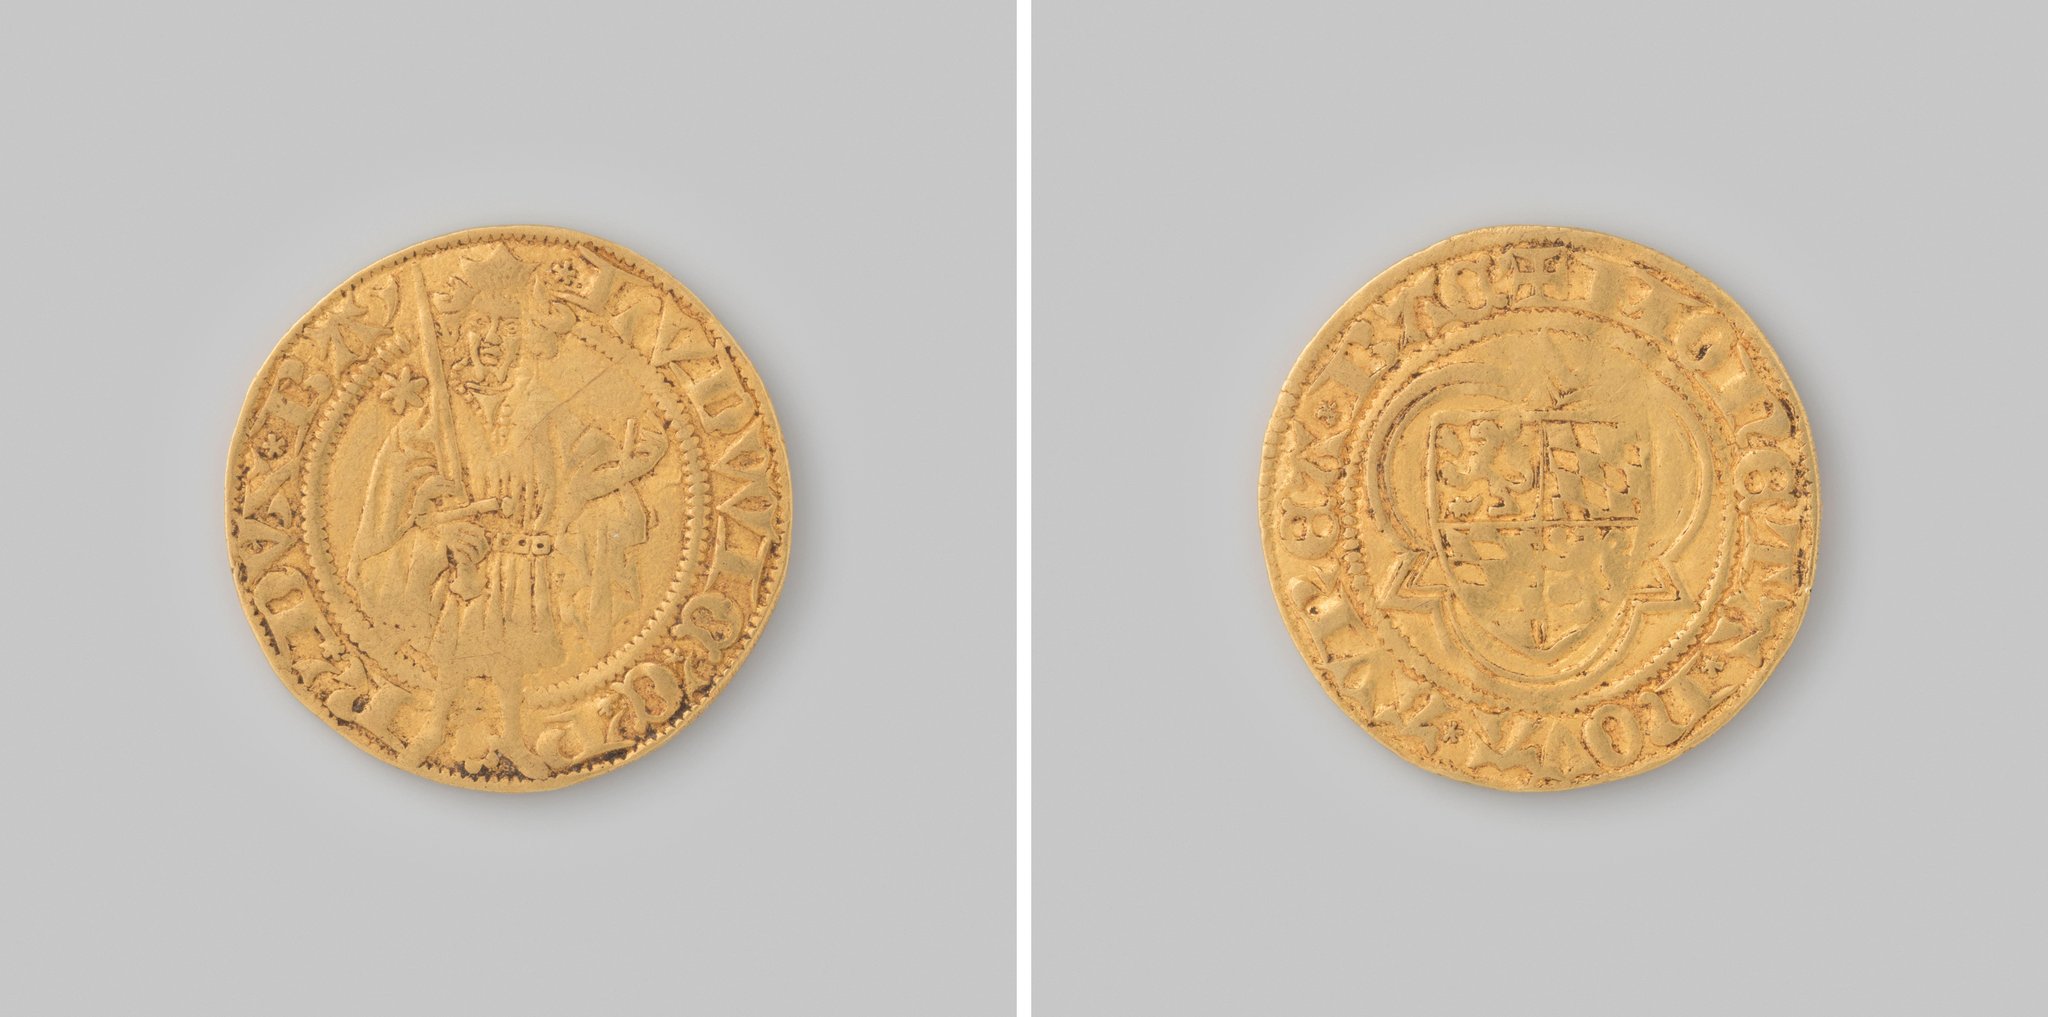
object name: goudgulden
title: Goudgulden uit de Palts aan de Rijn van keurvorst Ludwig III, 1410-1436, afkomstig uit schatvondst Brielle 1929 (Merula weeshuis).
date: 1410-1436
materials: gold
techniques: striking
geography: bacharach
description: Gouden munt. Voorzijde: staande keurvorst met in rechterhand zwaard. Links daarvan een ster in het veld. Keerzijde: binnen dubbellijnige versierde driepas samengesteld wapenschild. Munt afkomstig uit muntvondst Merula weeshuis Brielle 1929.